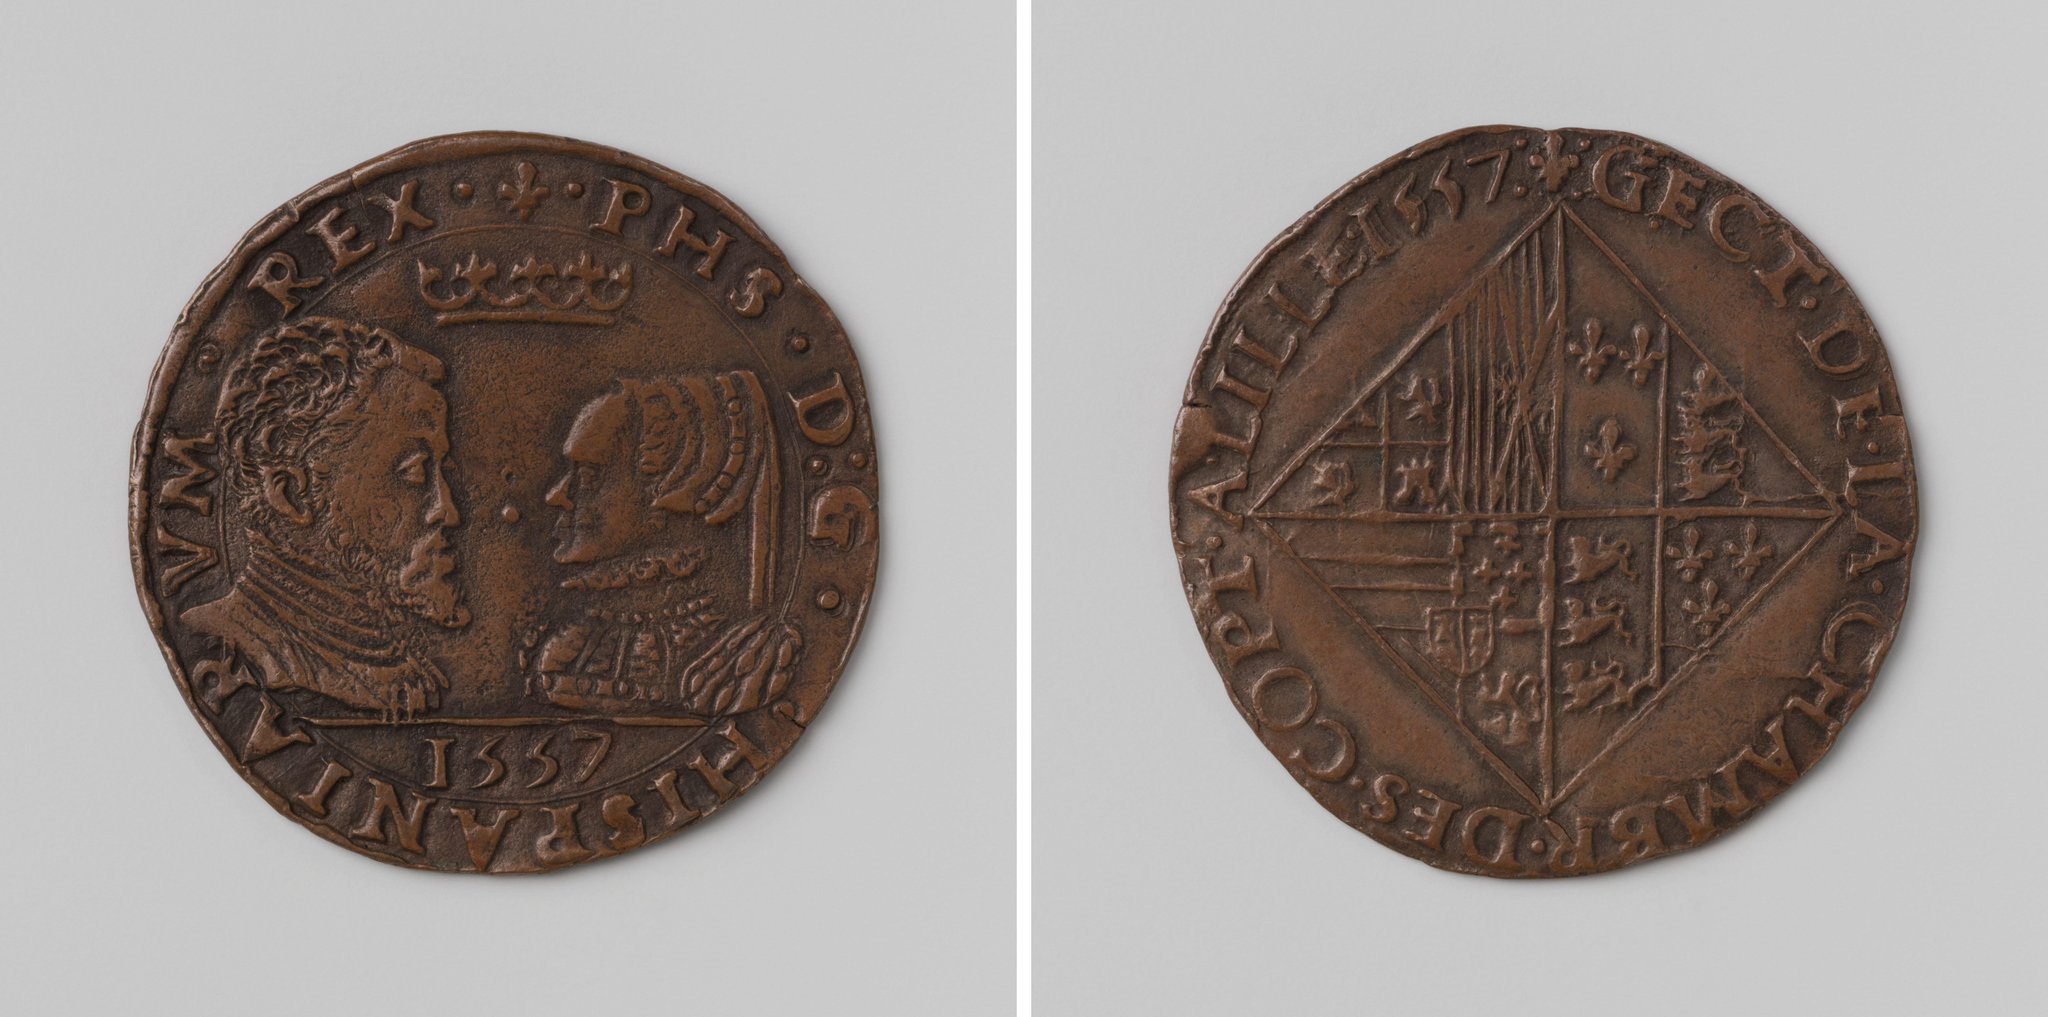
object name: jeton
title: Filips II, koning van Spanje en Maria I, koningin van Engeland, rekenpenning van de rekenkamer van Vlaanderen te Rijssel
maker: Anonymous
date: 1557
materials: copper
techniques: striking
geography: flanders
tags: philip ii of spain, london, lille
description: Koperen penning. Voorzijde: naar elkaar gewende borststukken man en vrouw onder een kroon binnen omschrift; afsnede: jaartal. Keerzijde: ruitvormig wapenschild binnen omschrift